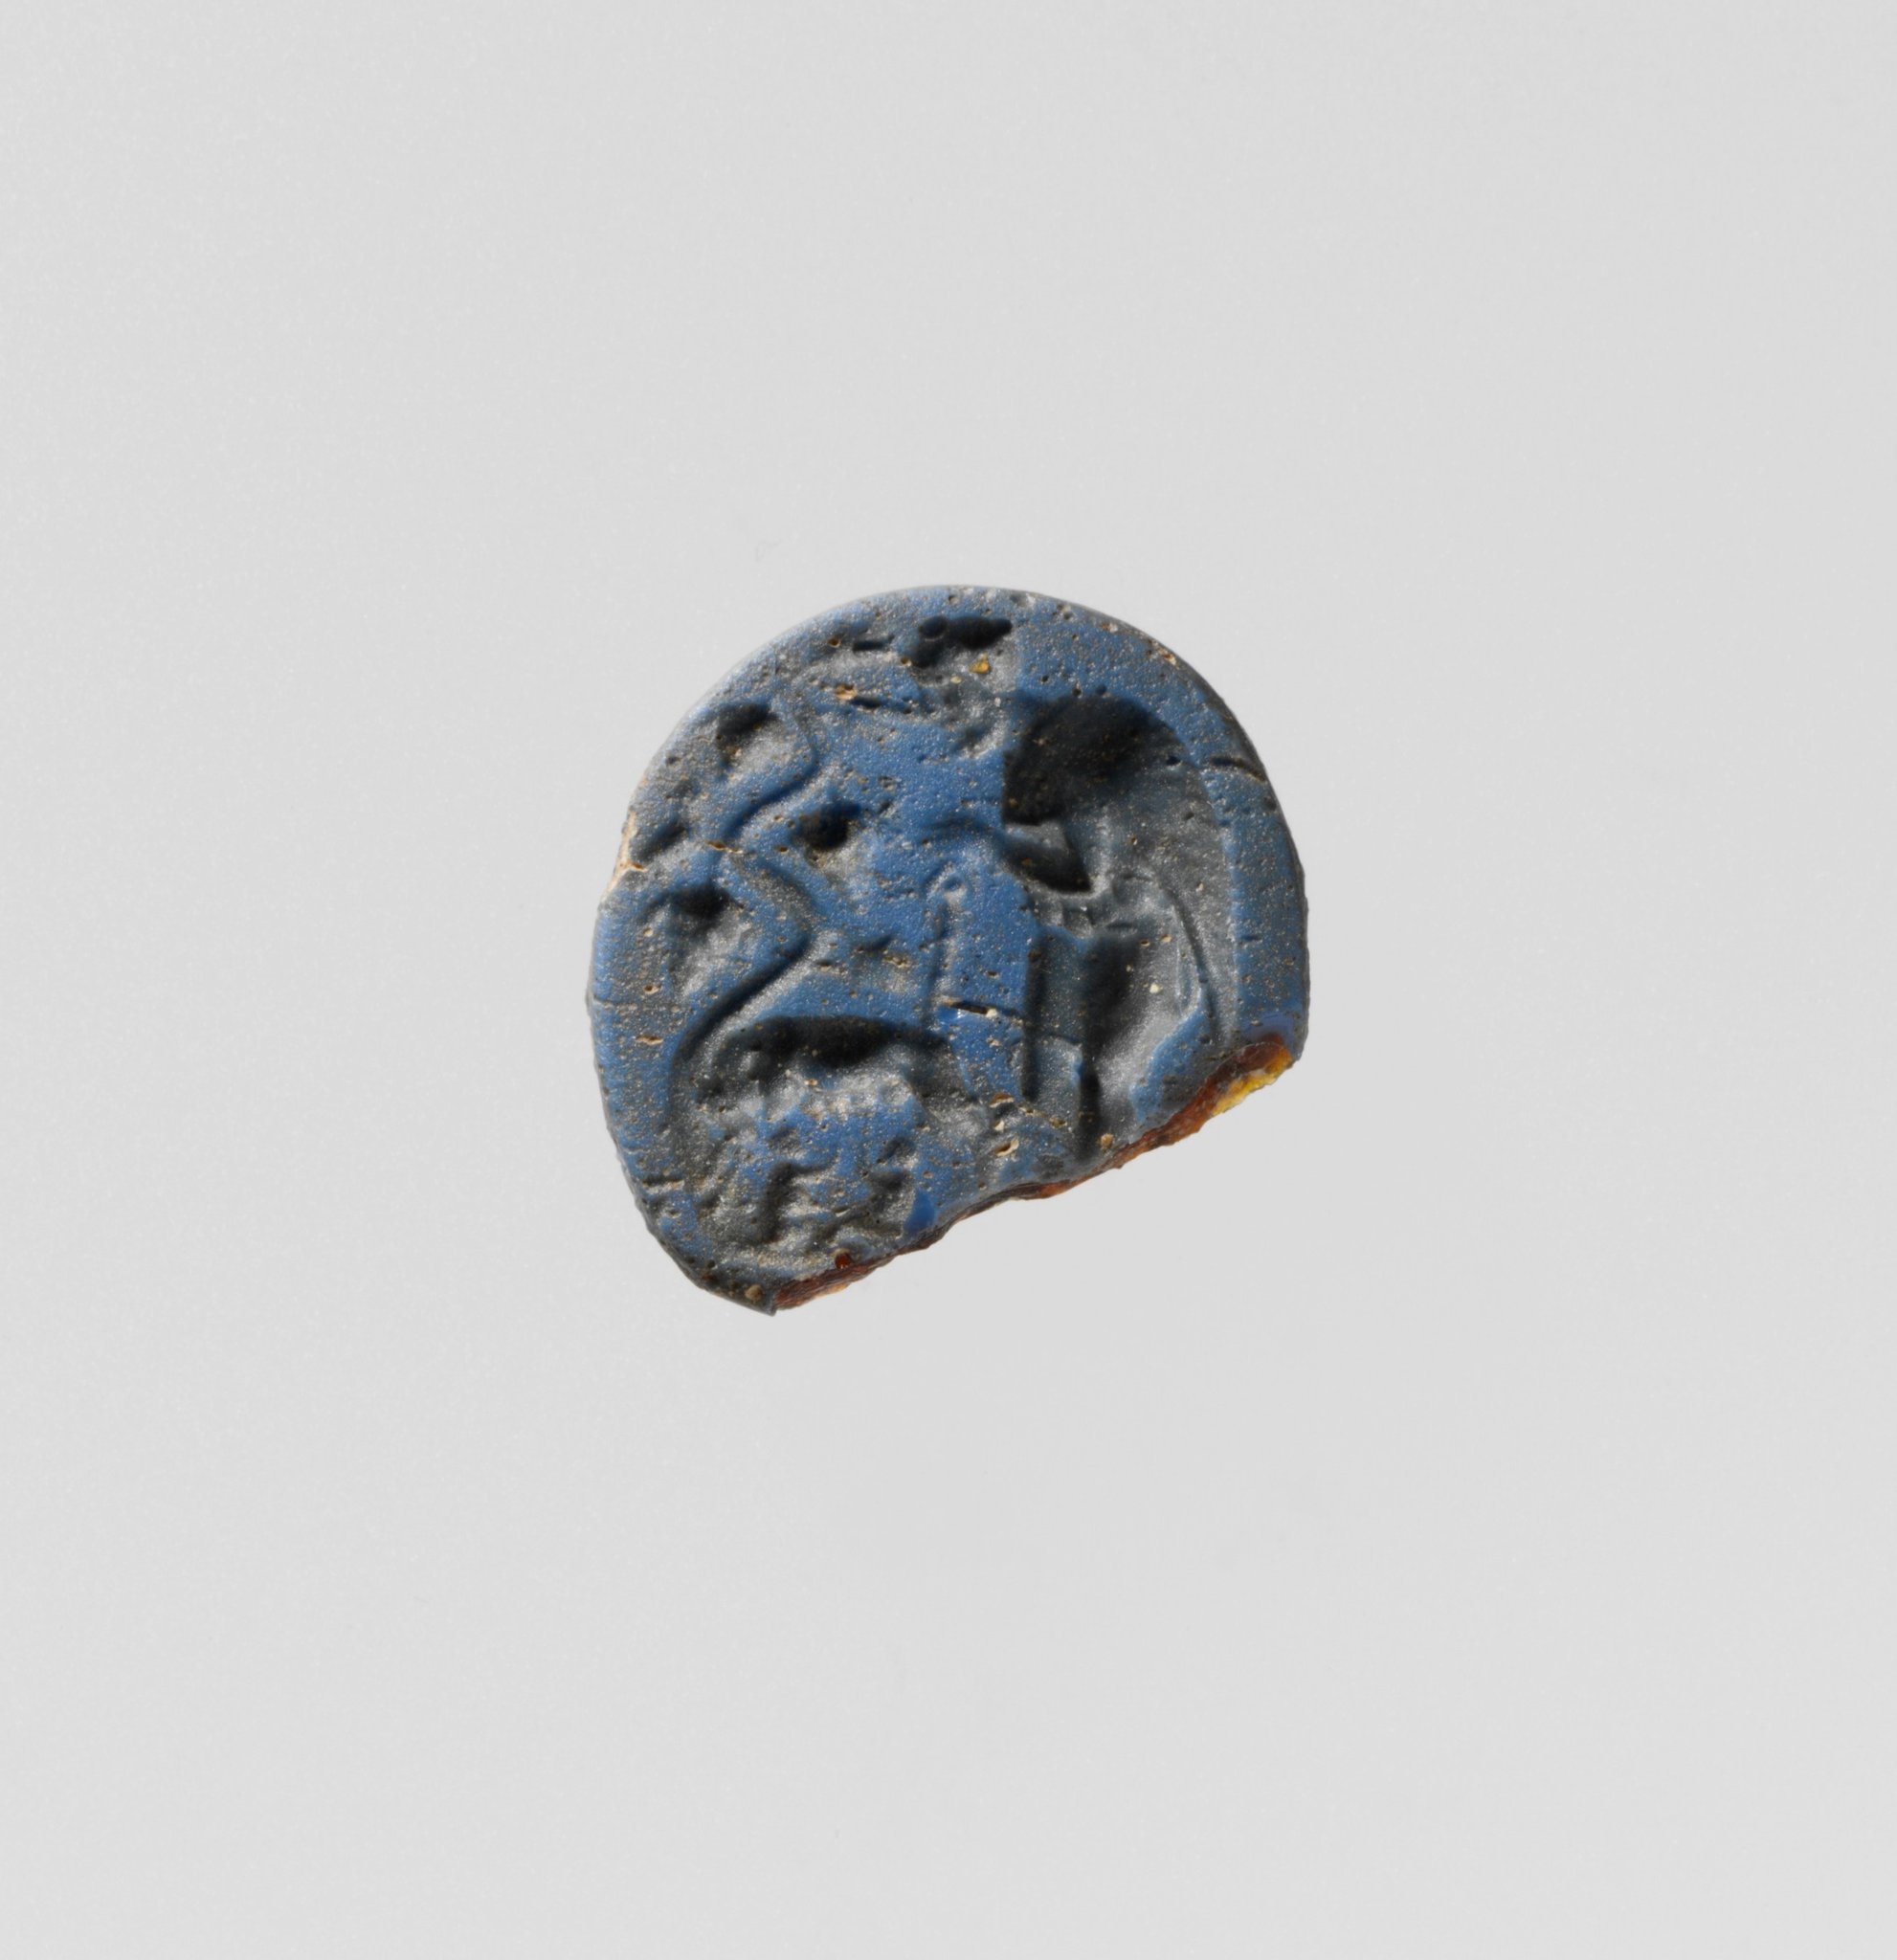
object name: intaglio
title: Opaque blue glass oval engraved gem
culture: roman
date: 100-1 BCE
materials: glass, paste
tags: animals,infants,vines,shepherds